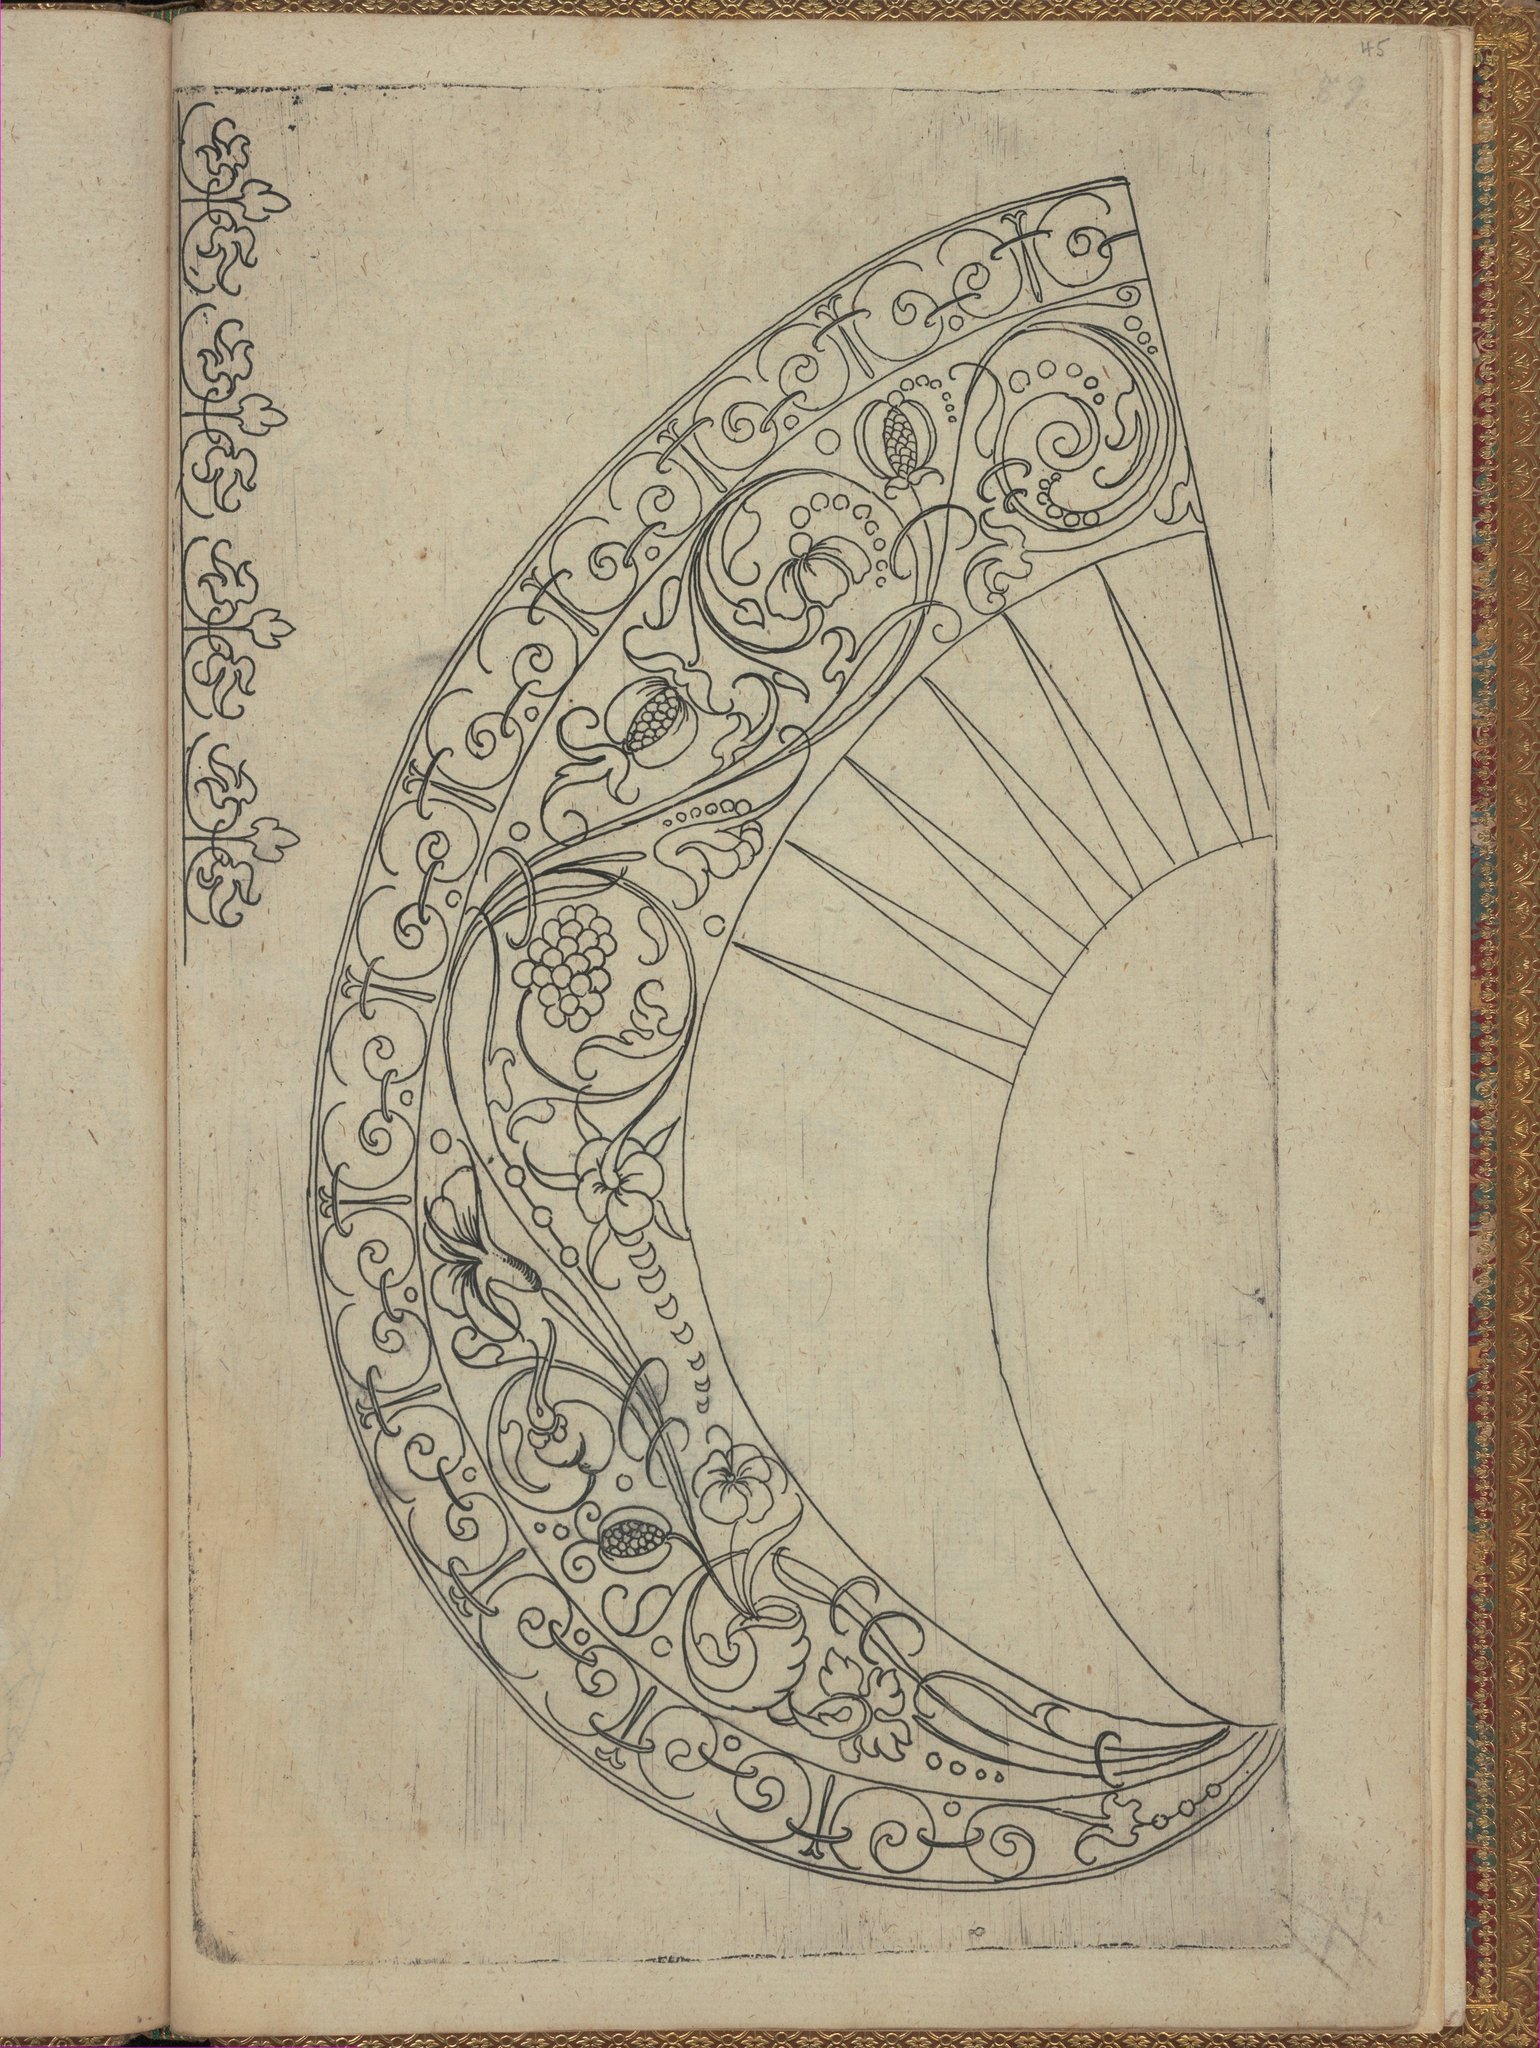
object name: book print ornament architecture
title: New Modelbüch (Page 45r)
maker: andreas bretschneider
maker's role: designer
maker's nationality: german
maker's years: 1573-1645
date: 1615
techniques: etching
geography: germany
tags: flowers